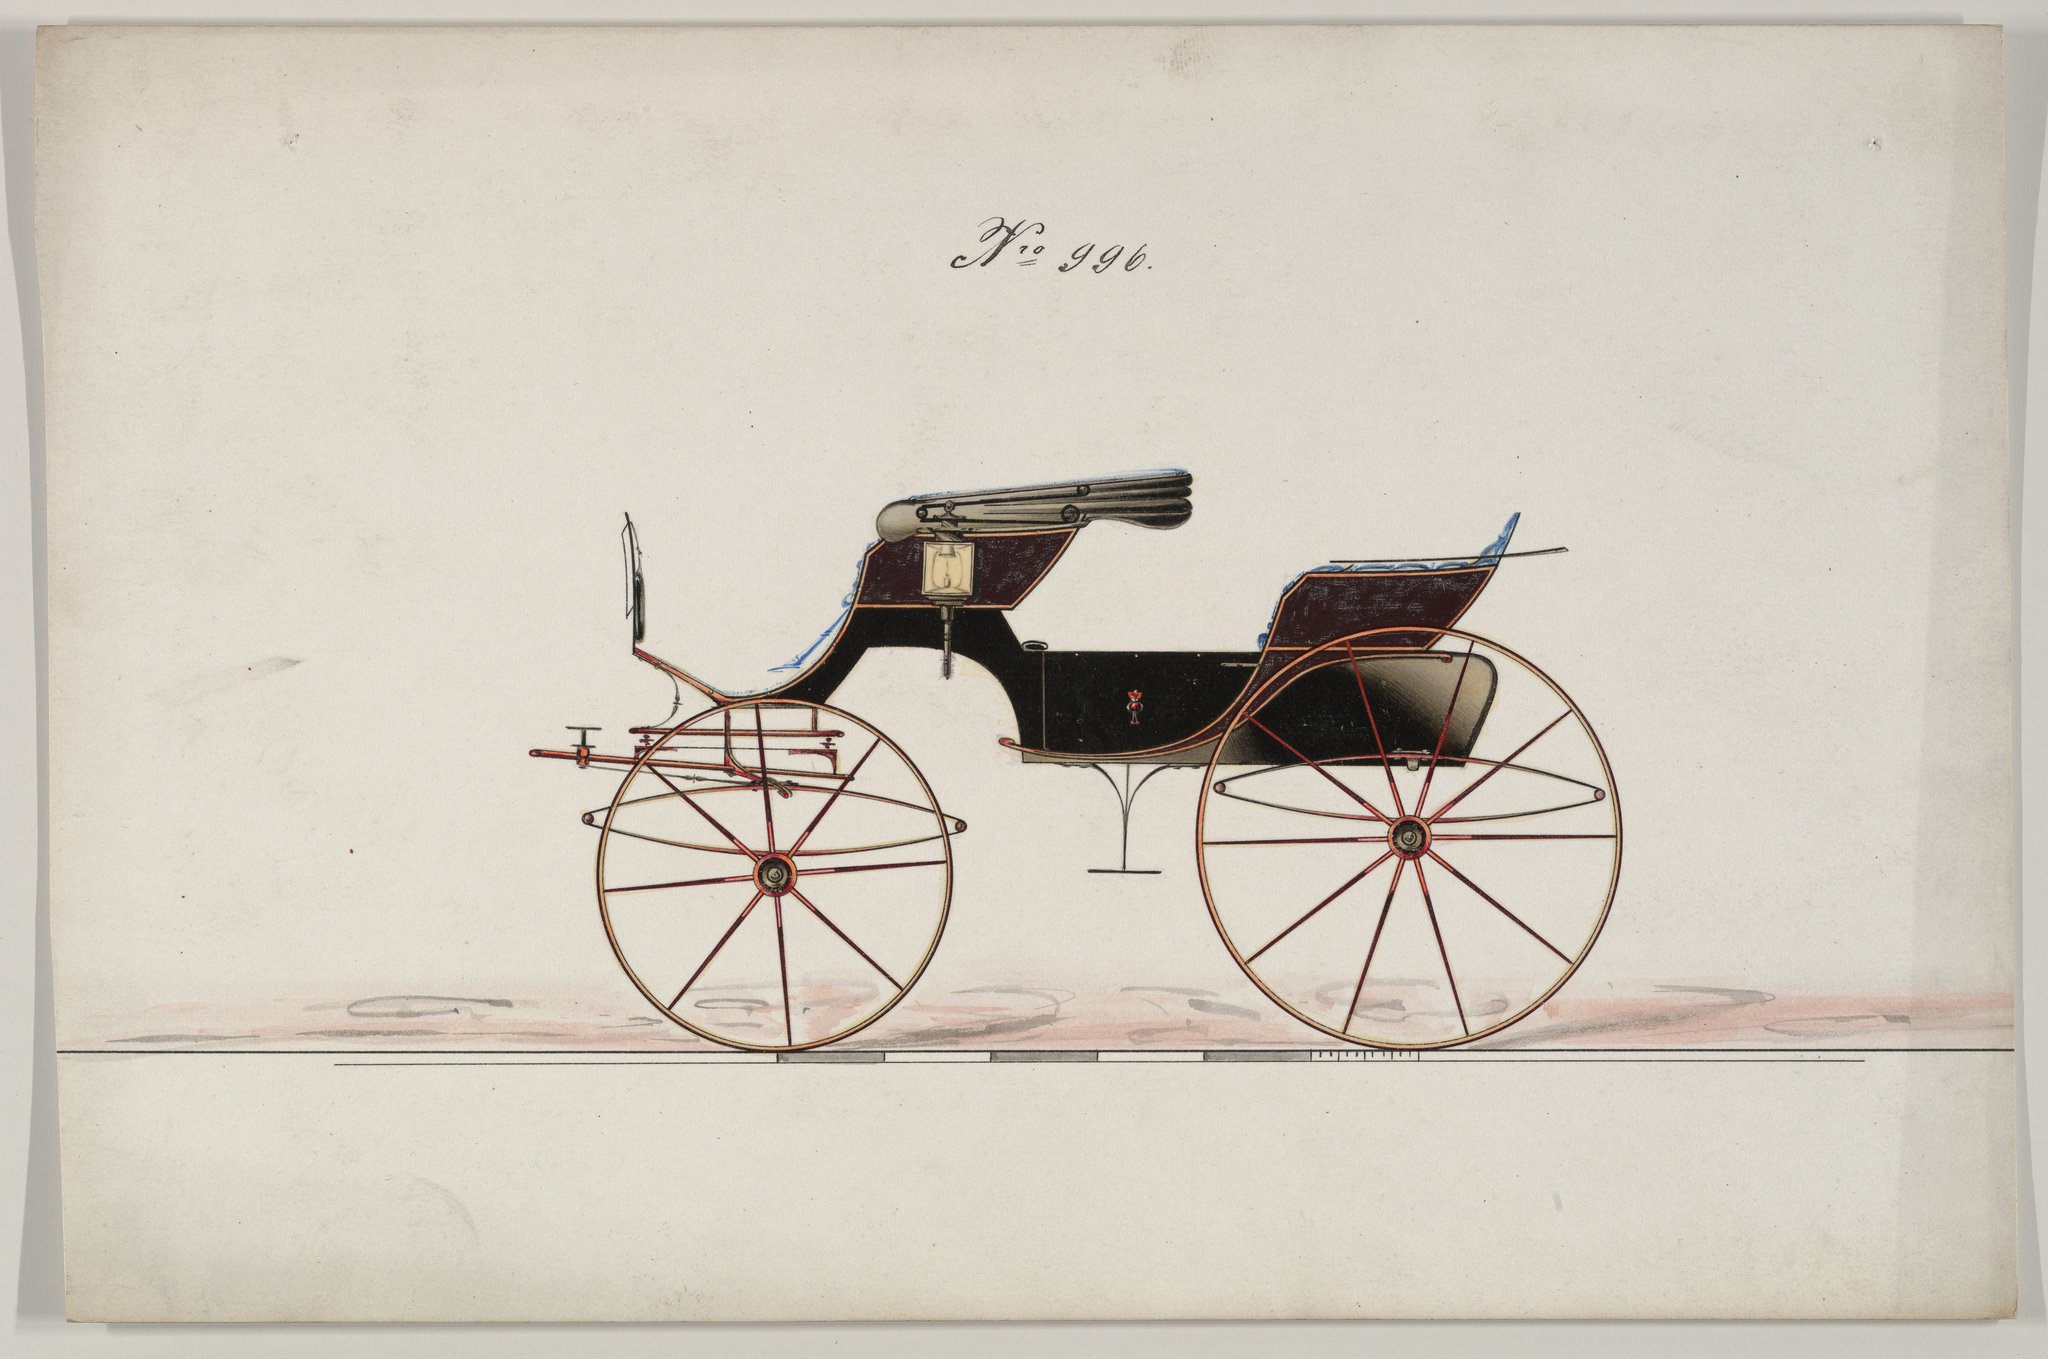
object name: drawing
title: Design for Phaeton, no. 996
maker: brewster & co.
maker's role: manufacturer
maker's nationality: american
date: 1850-1874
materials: gouache, gum arabic, ink, watercolor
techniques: pen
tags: carriages